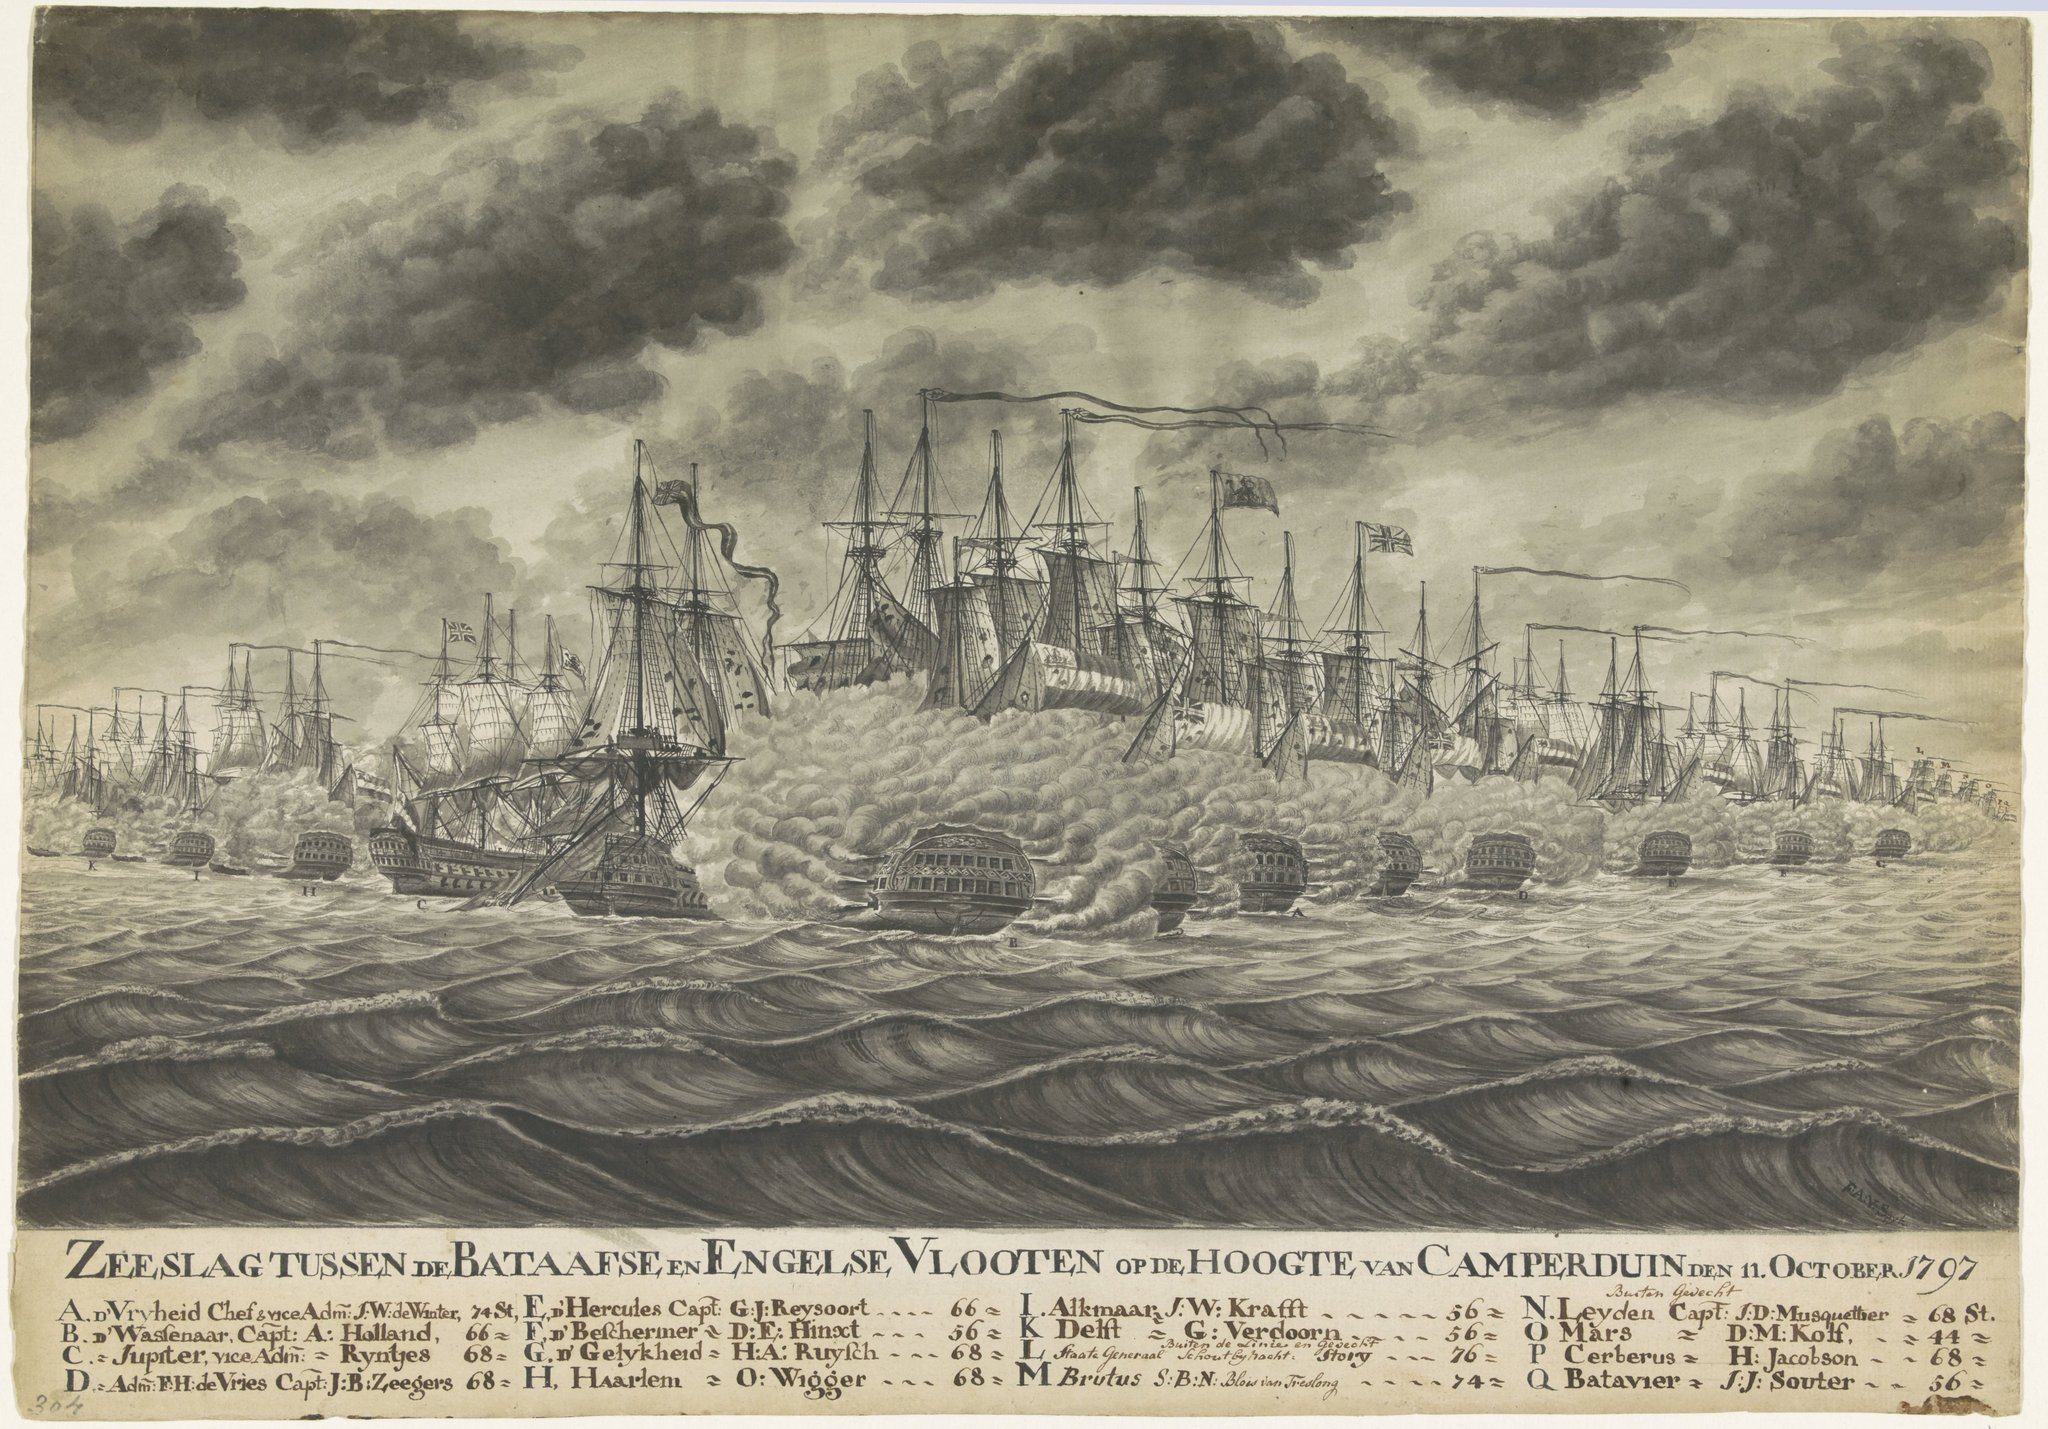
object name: drawing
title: Zeeslag tussen de Bataafse en Engelse Vlooten op de Hoogte van Camperduin den 11. October 1797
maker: frans anton van spijck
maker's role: print maker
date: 1797-1798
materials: paper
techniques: brush, pen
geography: netherlands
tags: paris, jan willem de winter, battle (+ naval force), battle of camperdown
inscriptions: collector's mark: Lugt 2228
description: De Zeeslag bij Kamperduin op 11 oktober 1797 tussen de Bataafse vloot onder bevel van viceadmiraal Jan Willem de Winter en een Britse vloot onder admiraal Adam Duncan. Aanvang van de slag met de schepen van de twee vloten omgeven door dikke rookwolken. Onder zwaar bewolkte hemel. In het onderschrift een legenda A-Q van de Bataafse schepen met kapiteins en aantallen stukken. Zie pendant.